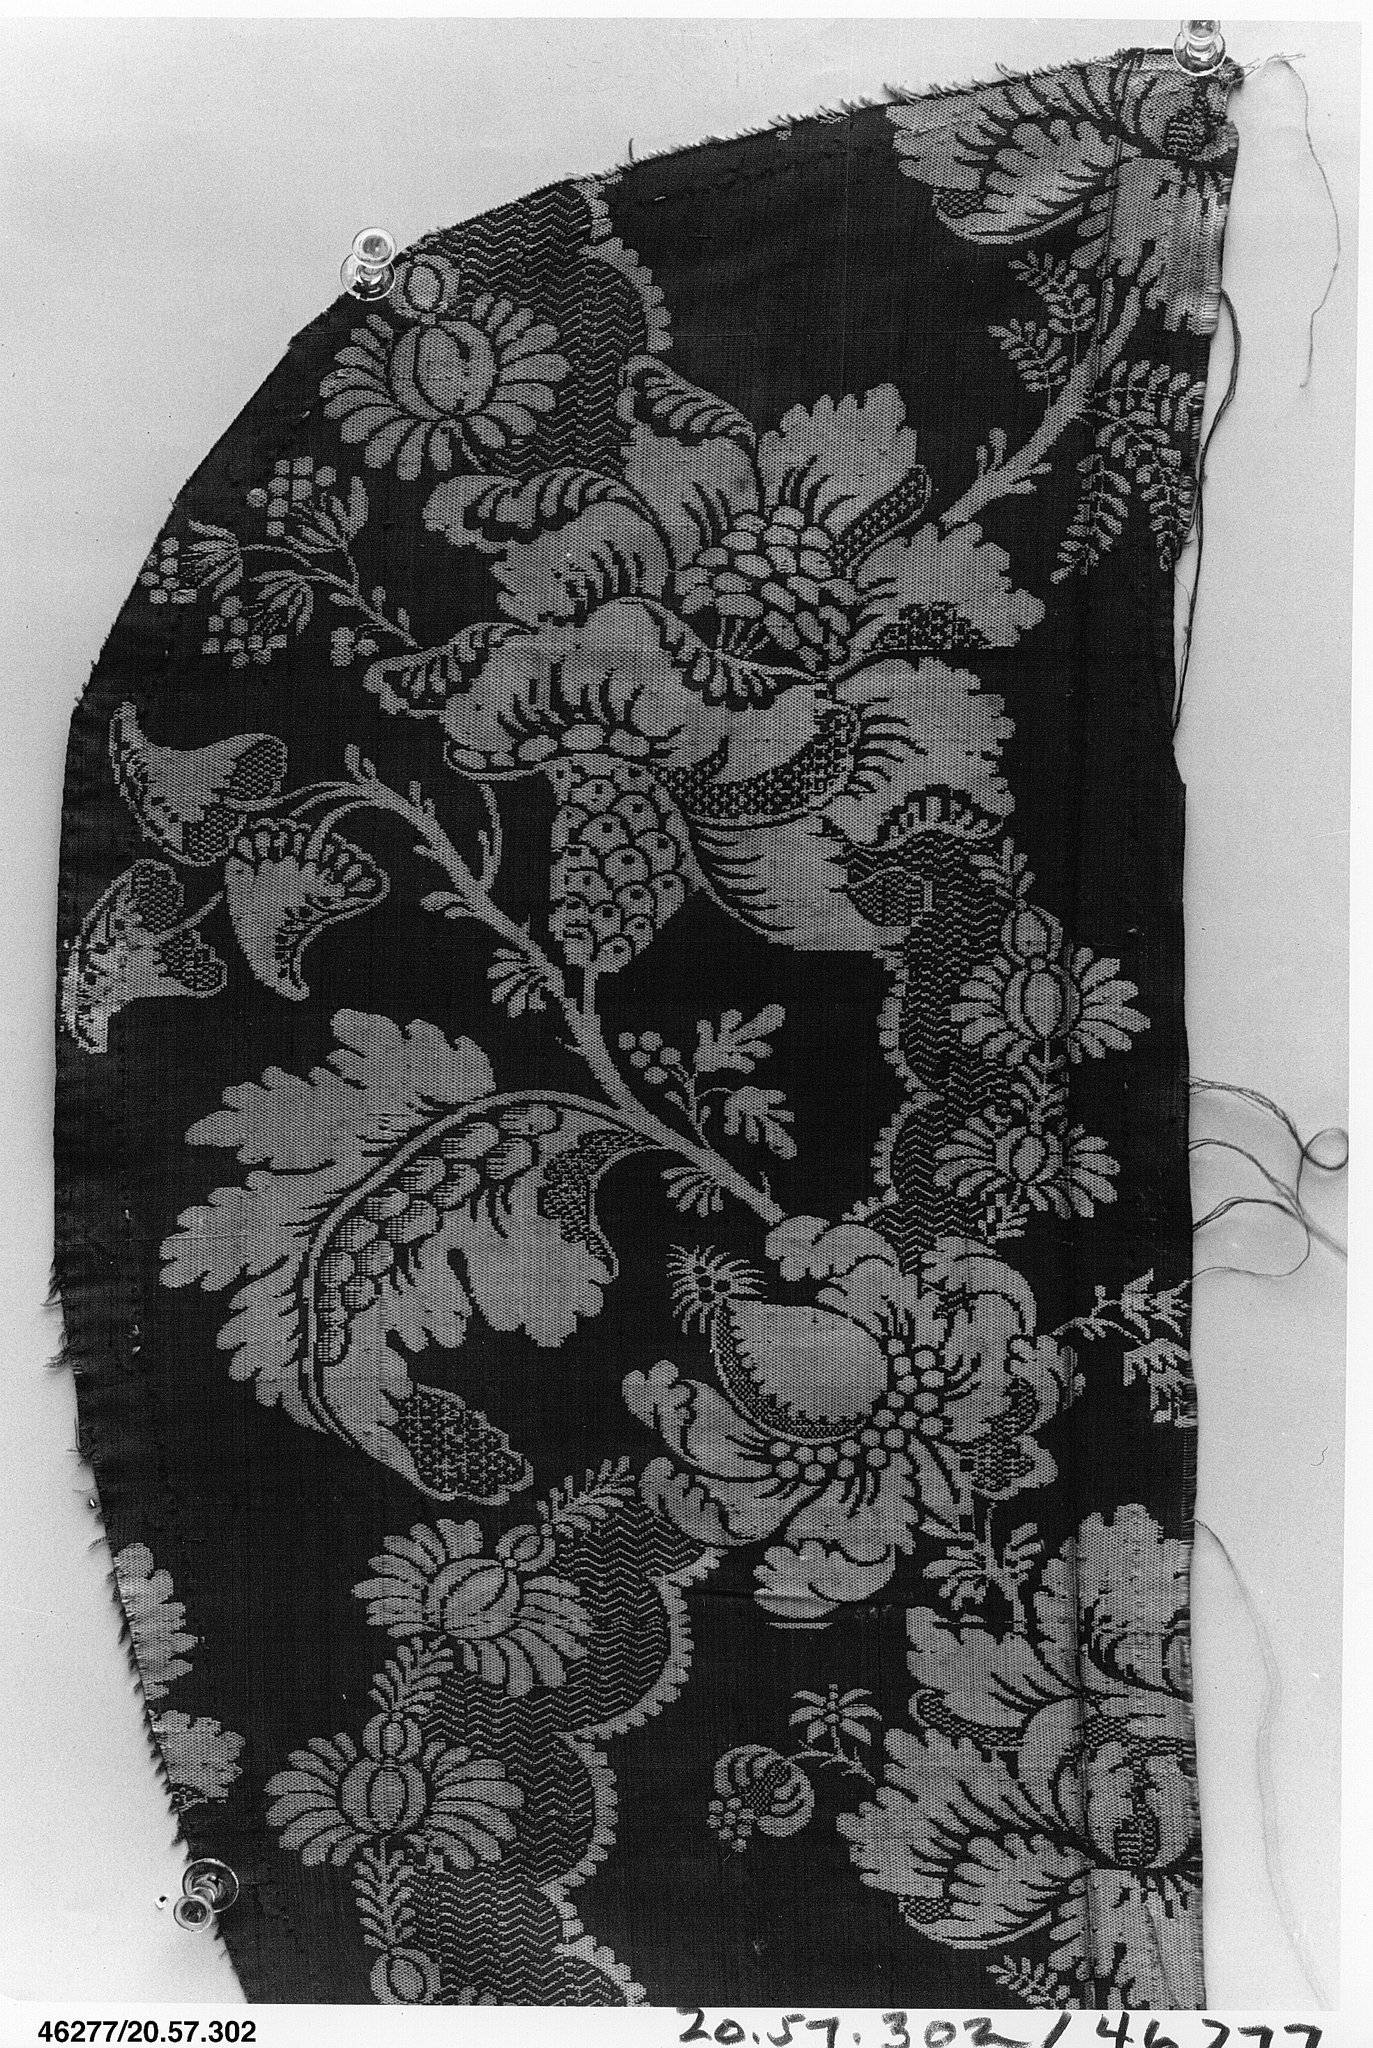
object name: piece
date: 1750-1760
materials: silk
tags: flowers,leaves